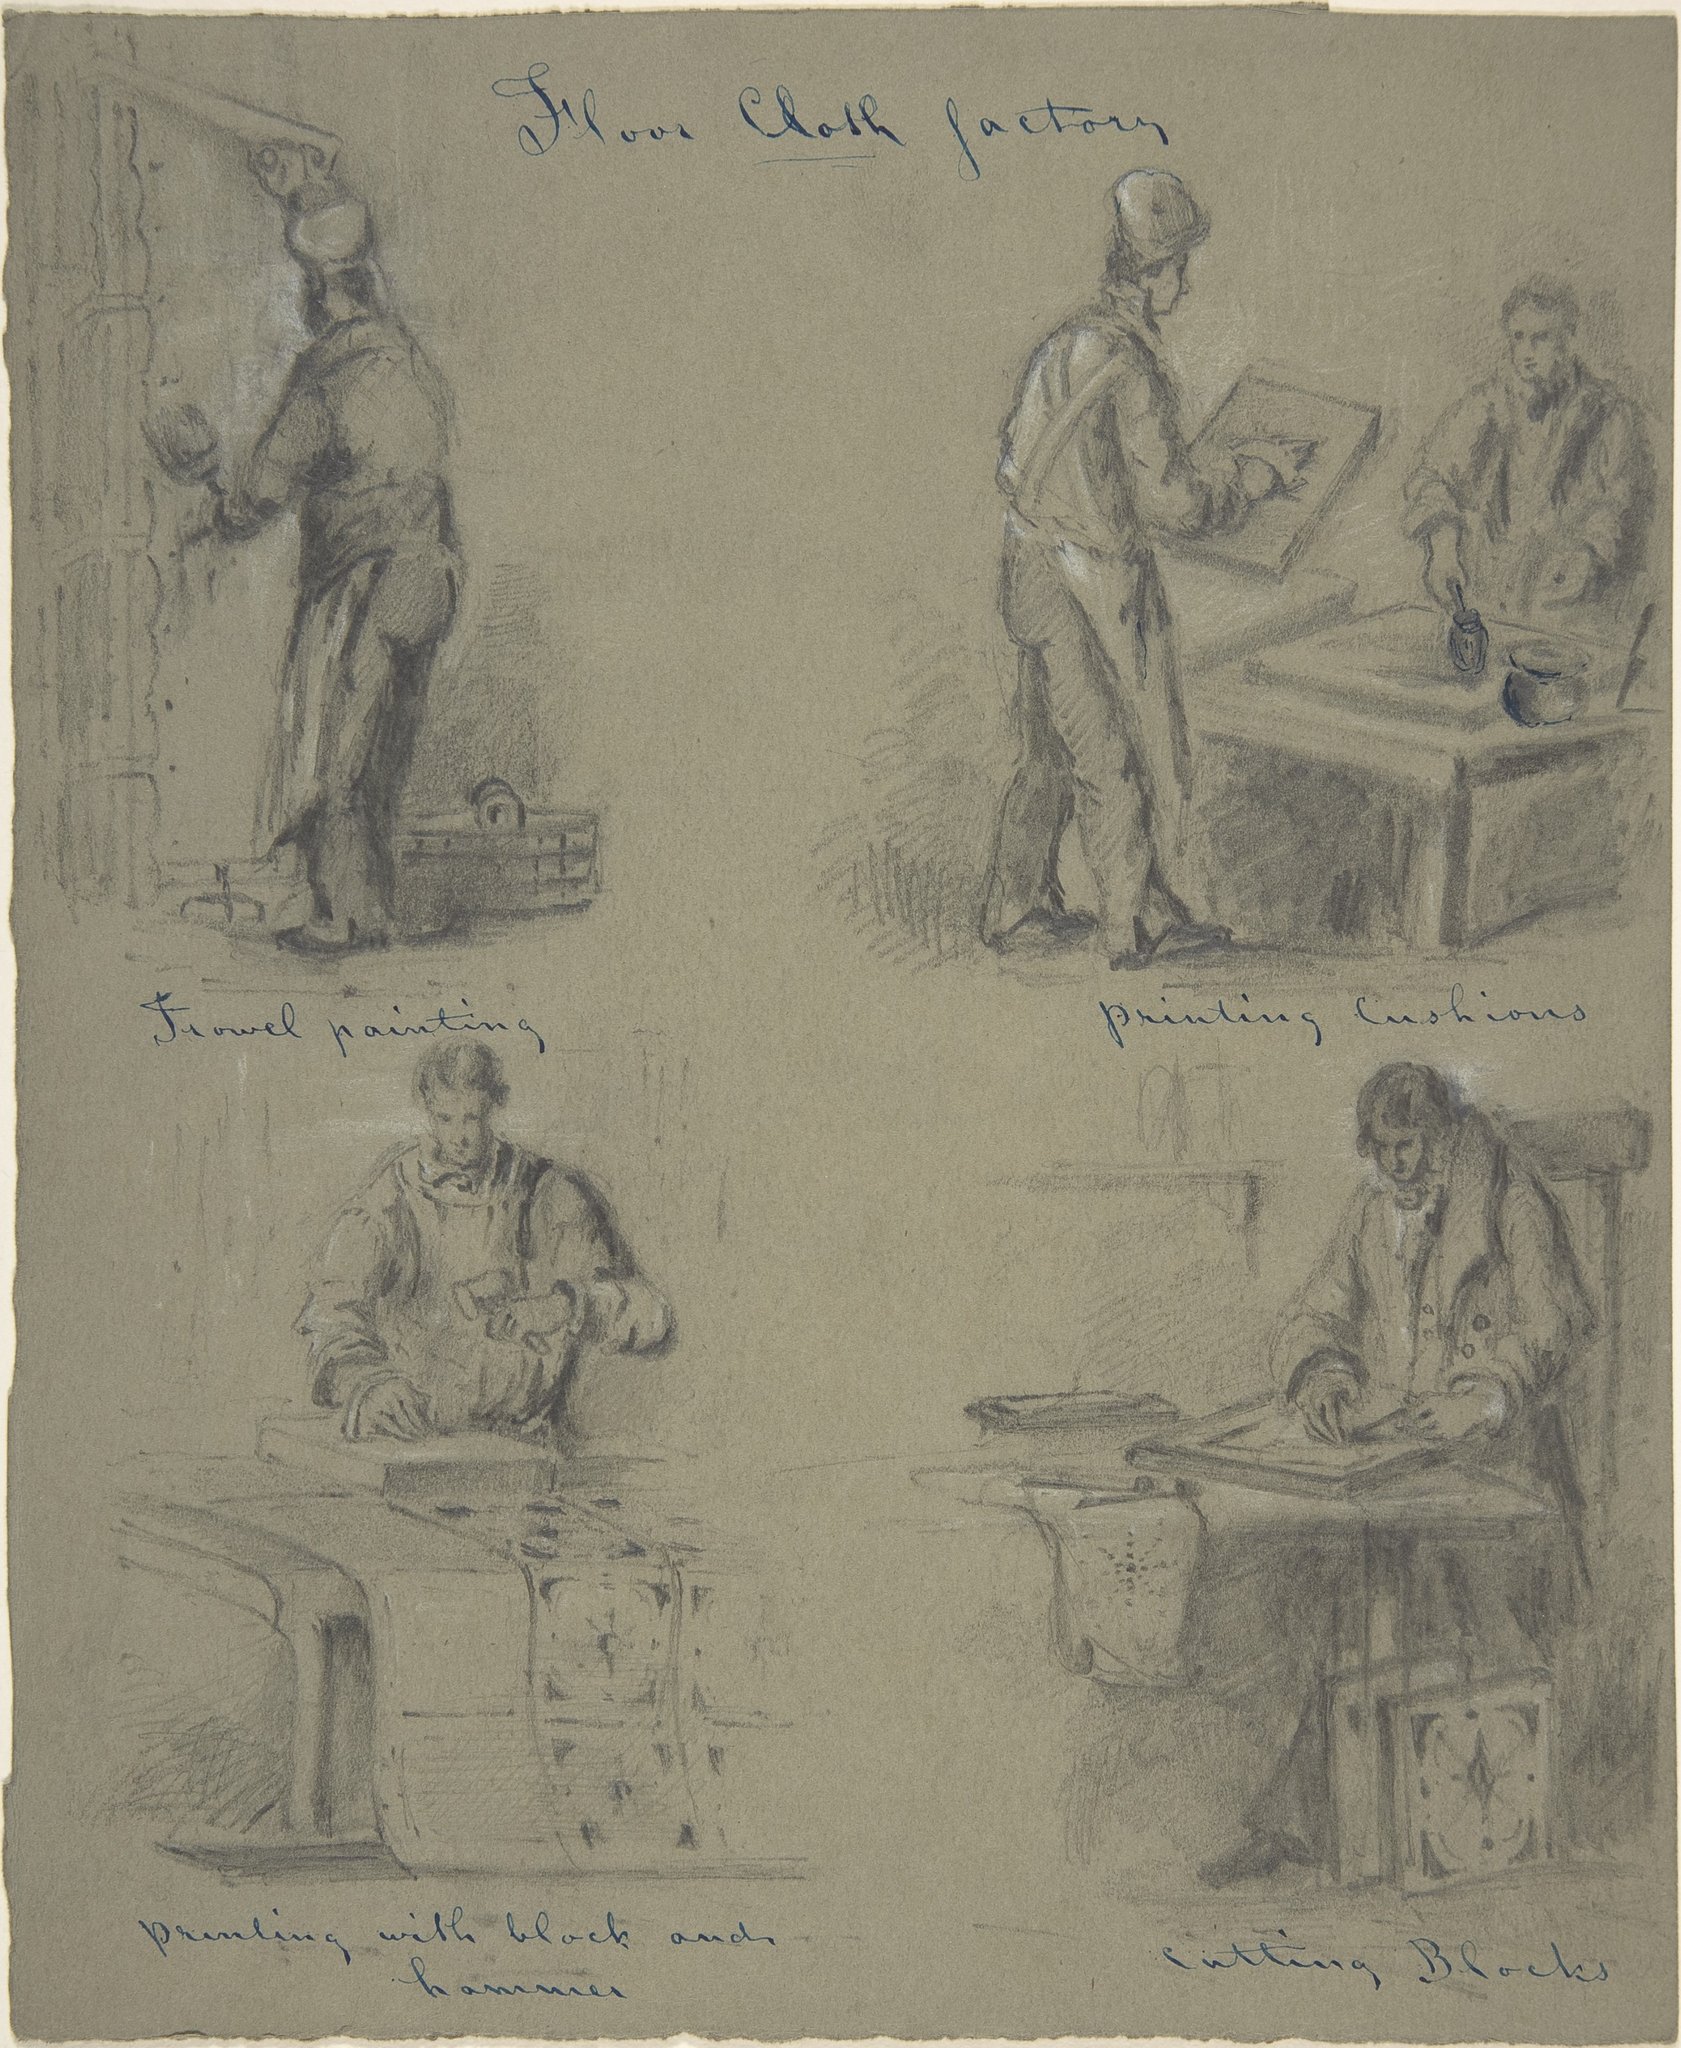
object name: drawing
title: Four drawings showing the manufacture of floor cloth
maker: anonymous, british, 19th century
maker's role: artist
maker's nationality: british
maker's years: 1800-1900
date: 1801-1900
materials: chalk, graphite, ink, paper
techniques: pen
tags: men,working